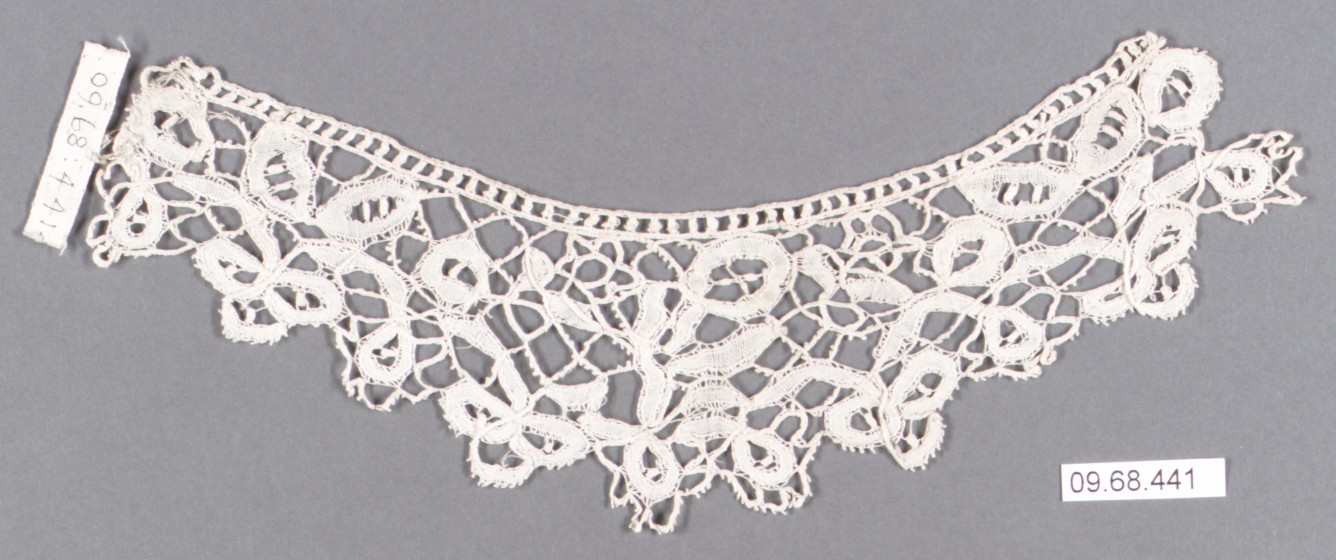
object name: cuff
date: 1801-1900